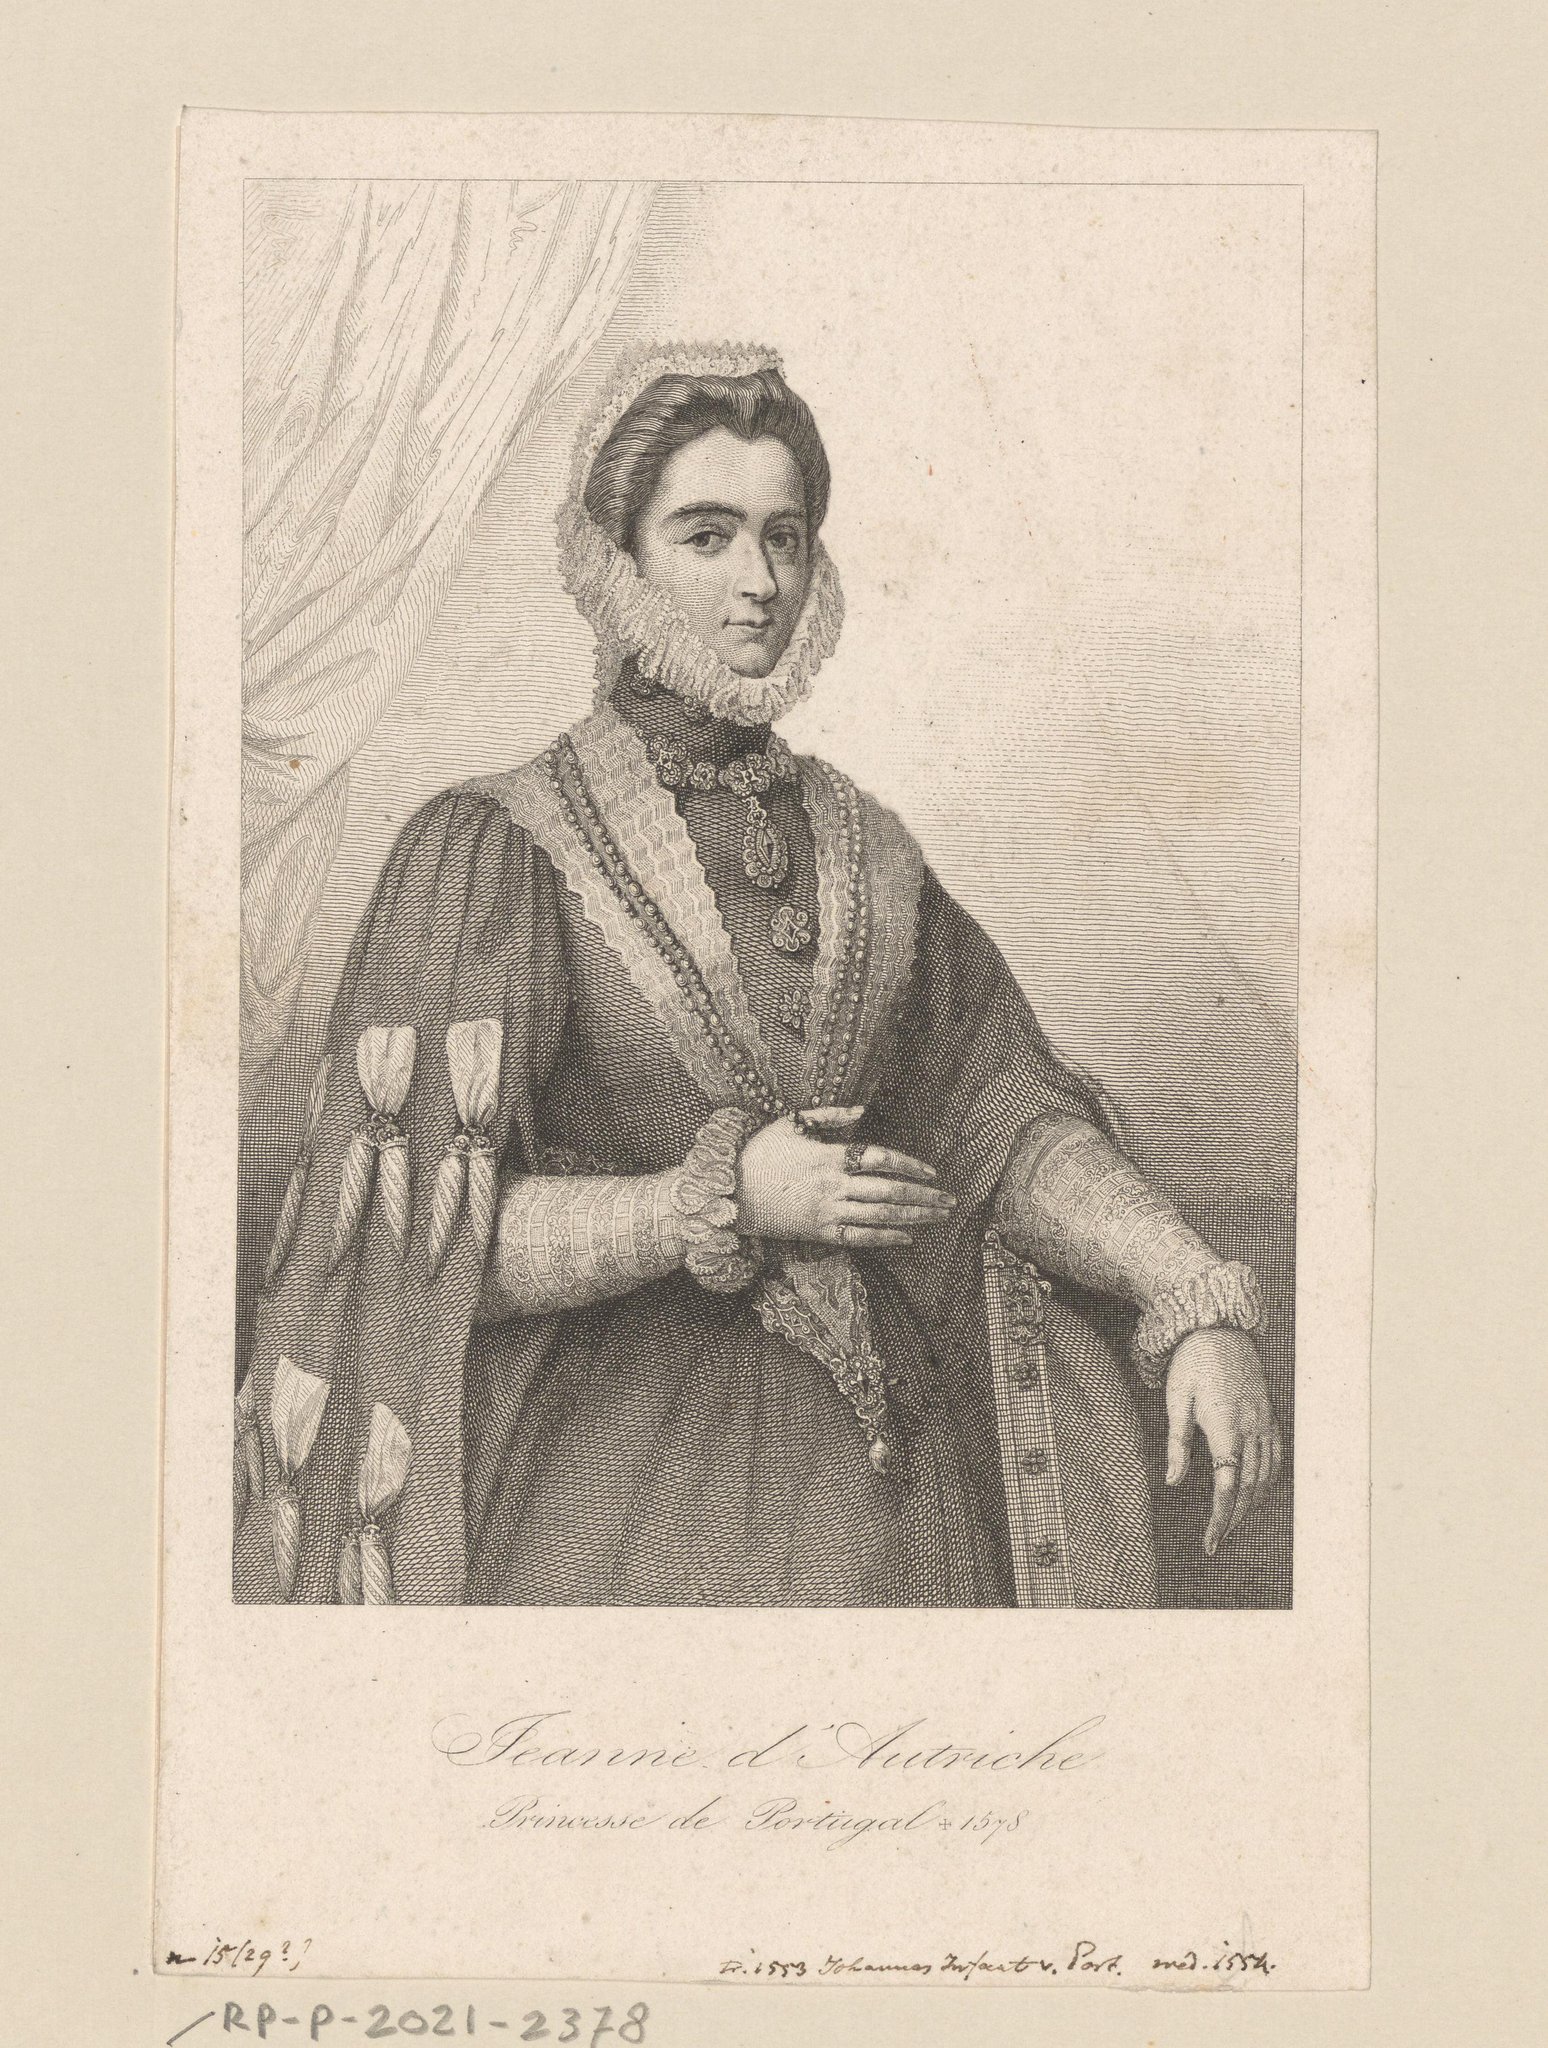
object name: print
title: Portret van Johanna van Oostenrijk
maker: Anonymous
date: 1750-1849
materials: paper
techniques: etching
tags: historical persons - bb - woman, nobility and patriciate; chivalry, knighthood